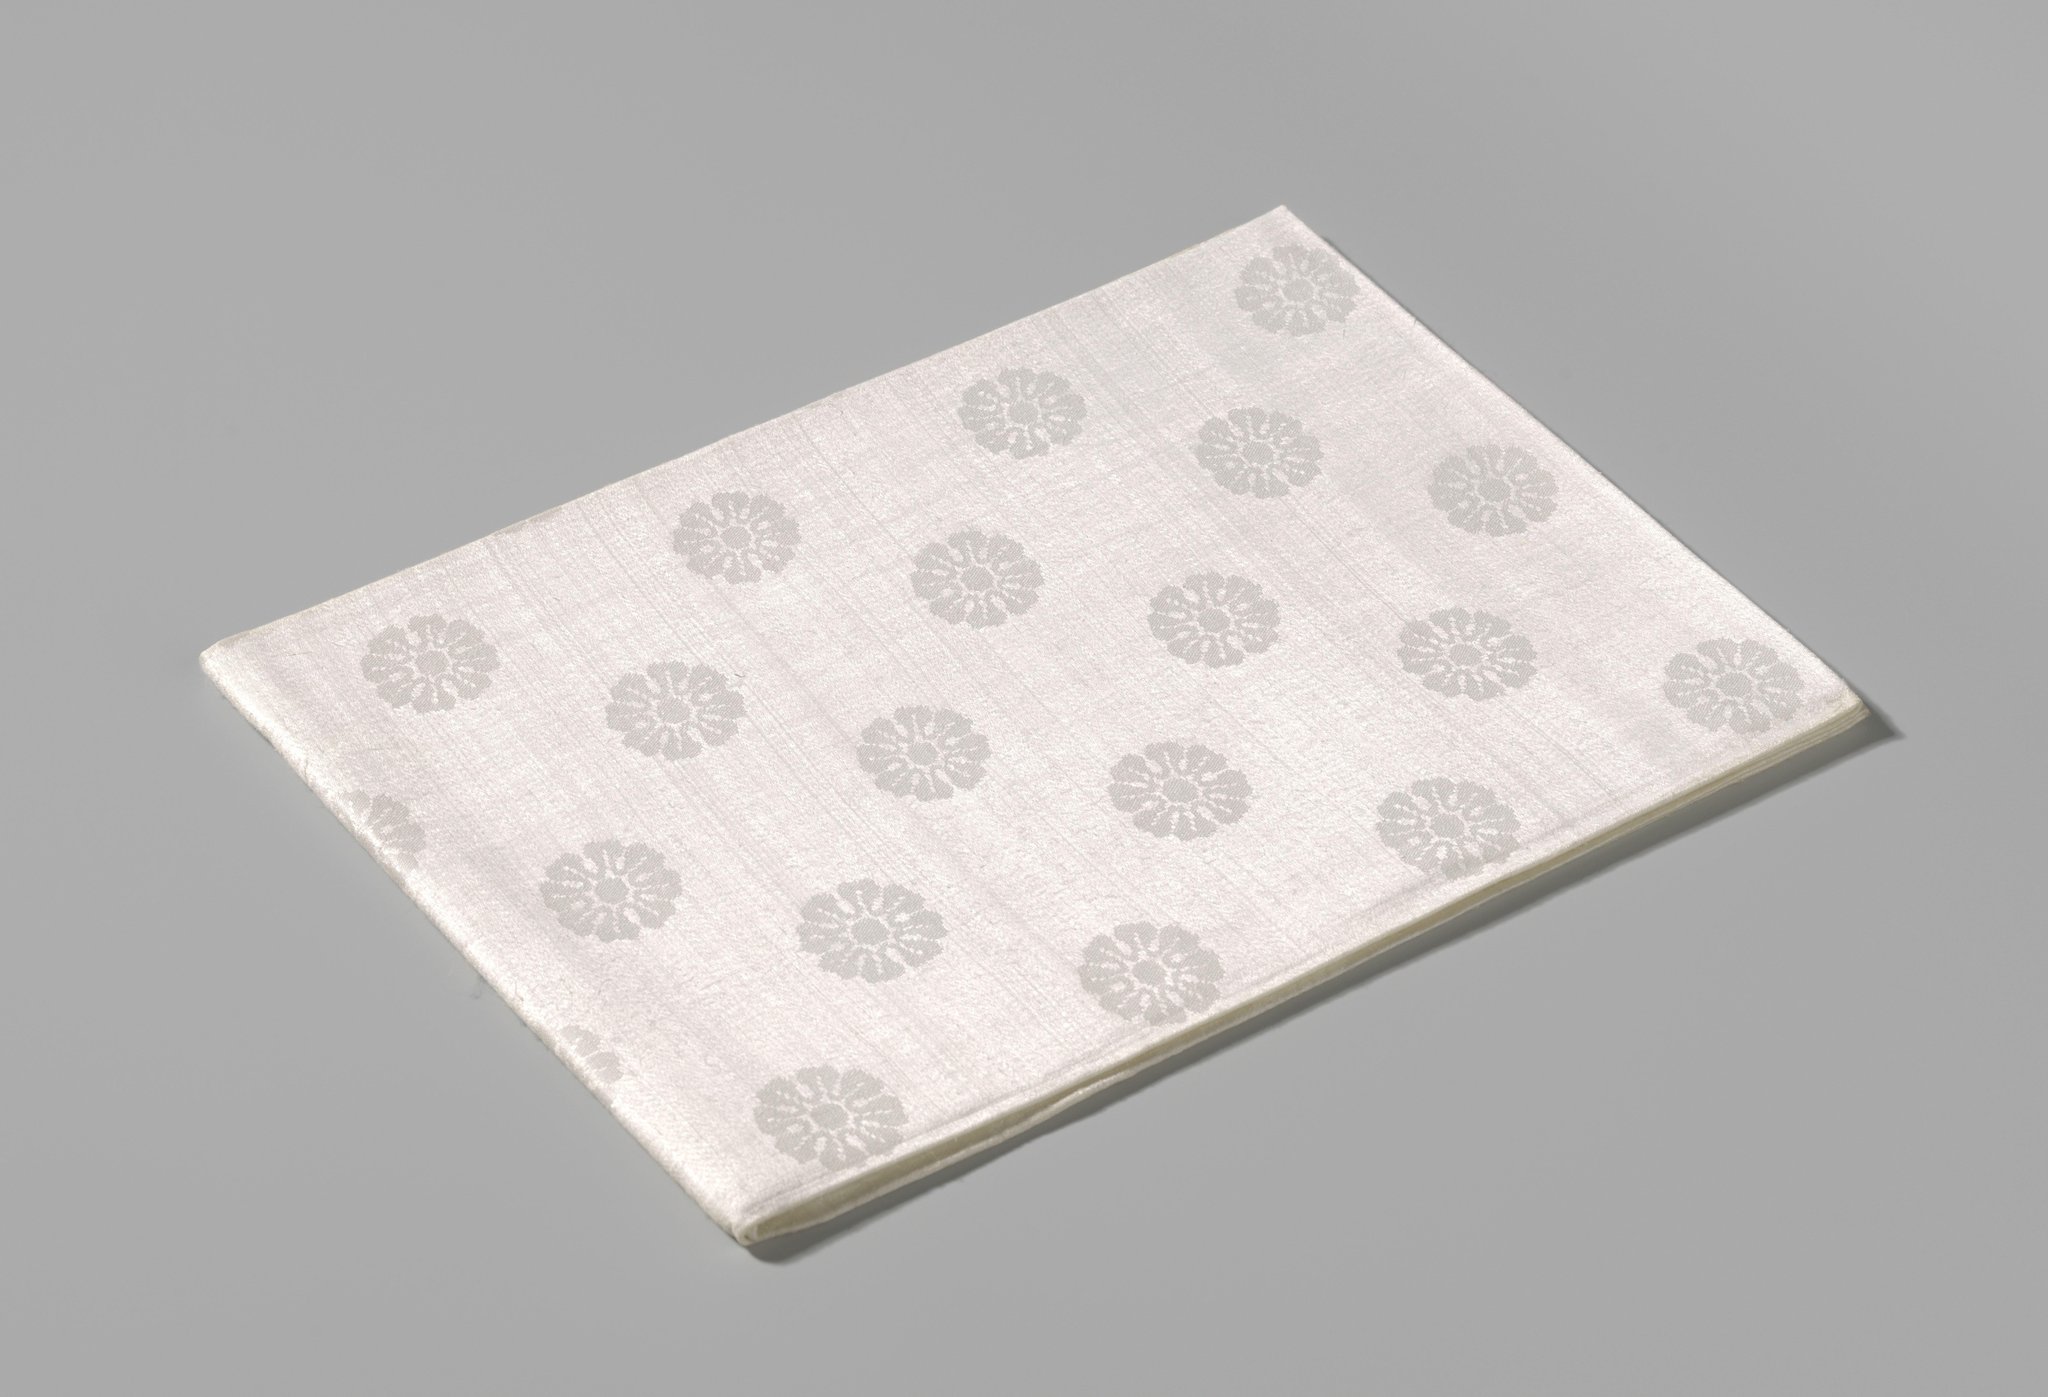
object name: napkin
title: Servet van linnendamast met een bloempatroon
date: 1849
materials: linen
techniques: damask, weave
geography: northern netherlands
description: Servet van linnendamast. Het veld heeft verspringende rijen rozetten en de rand heeft bloemen en acanthusbladeren. De hoeken hebben een vaas met vruchten. Het servet is gemerkt: HW36 1849. Het servet hoort bij dertien servetten (BK-1980-377-A t/m BK-1980-377-N).